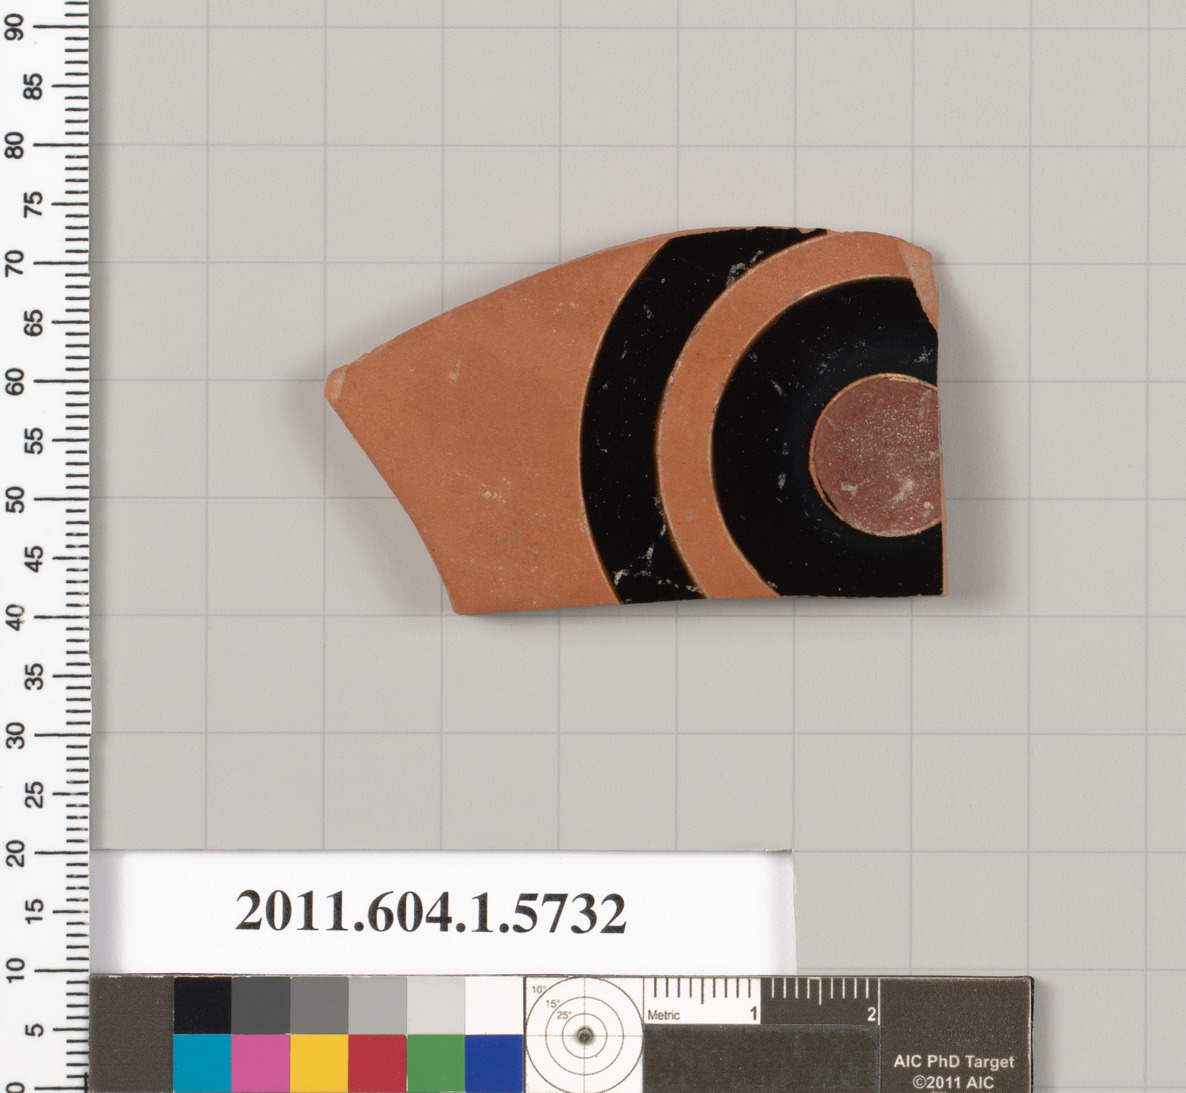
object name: kylix fragment, eye cup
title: Terracotta fragment of a kylix: eye-cup (drinking cup)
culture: greek, attic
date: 525-510 BCE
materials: terracotta